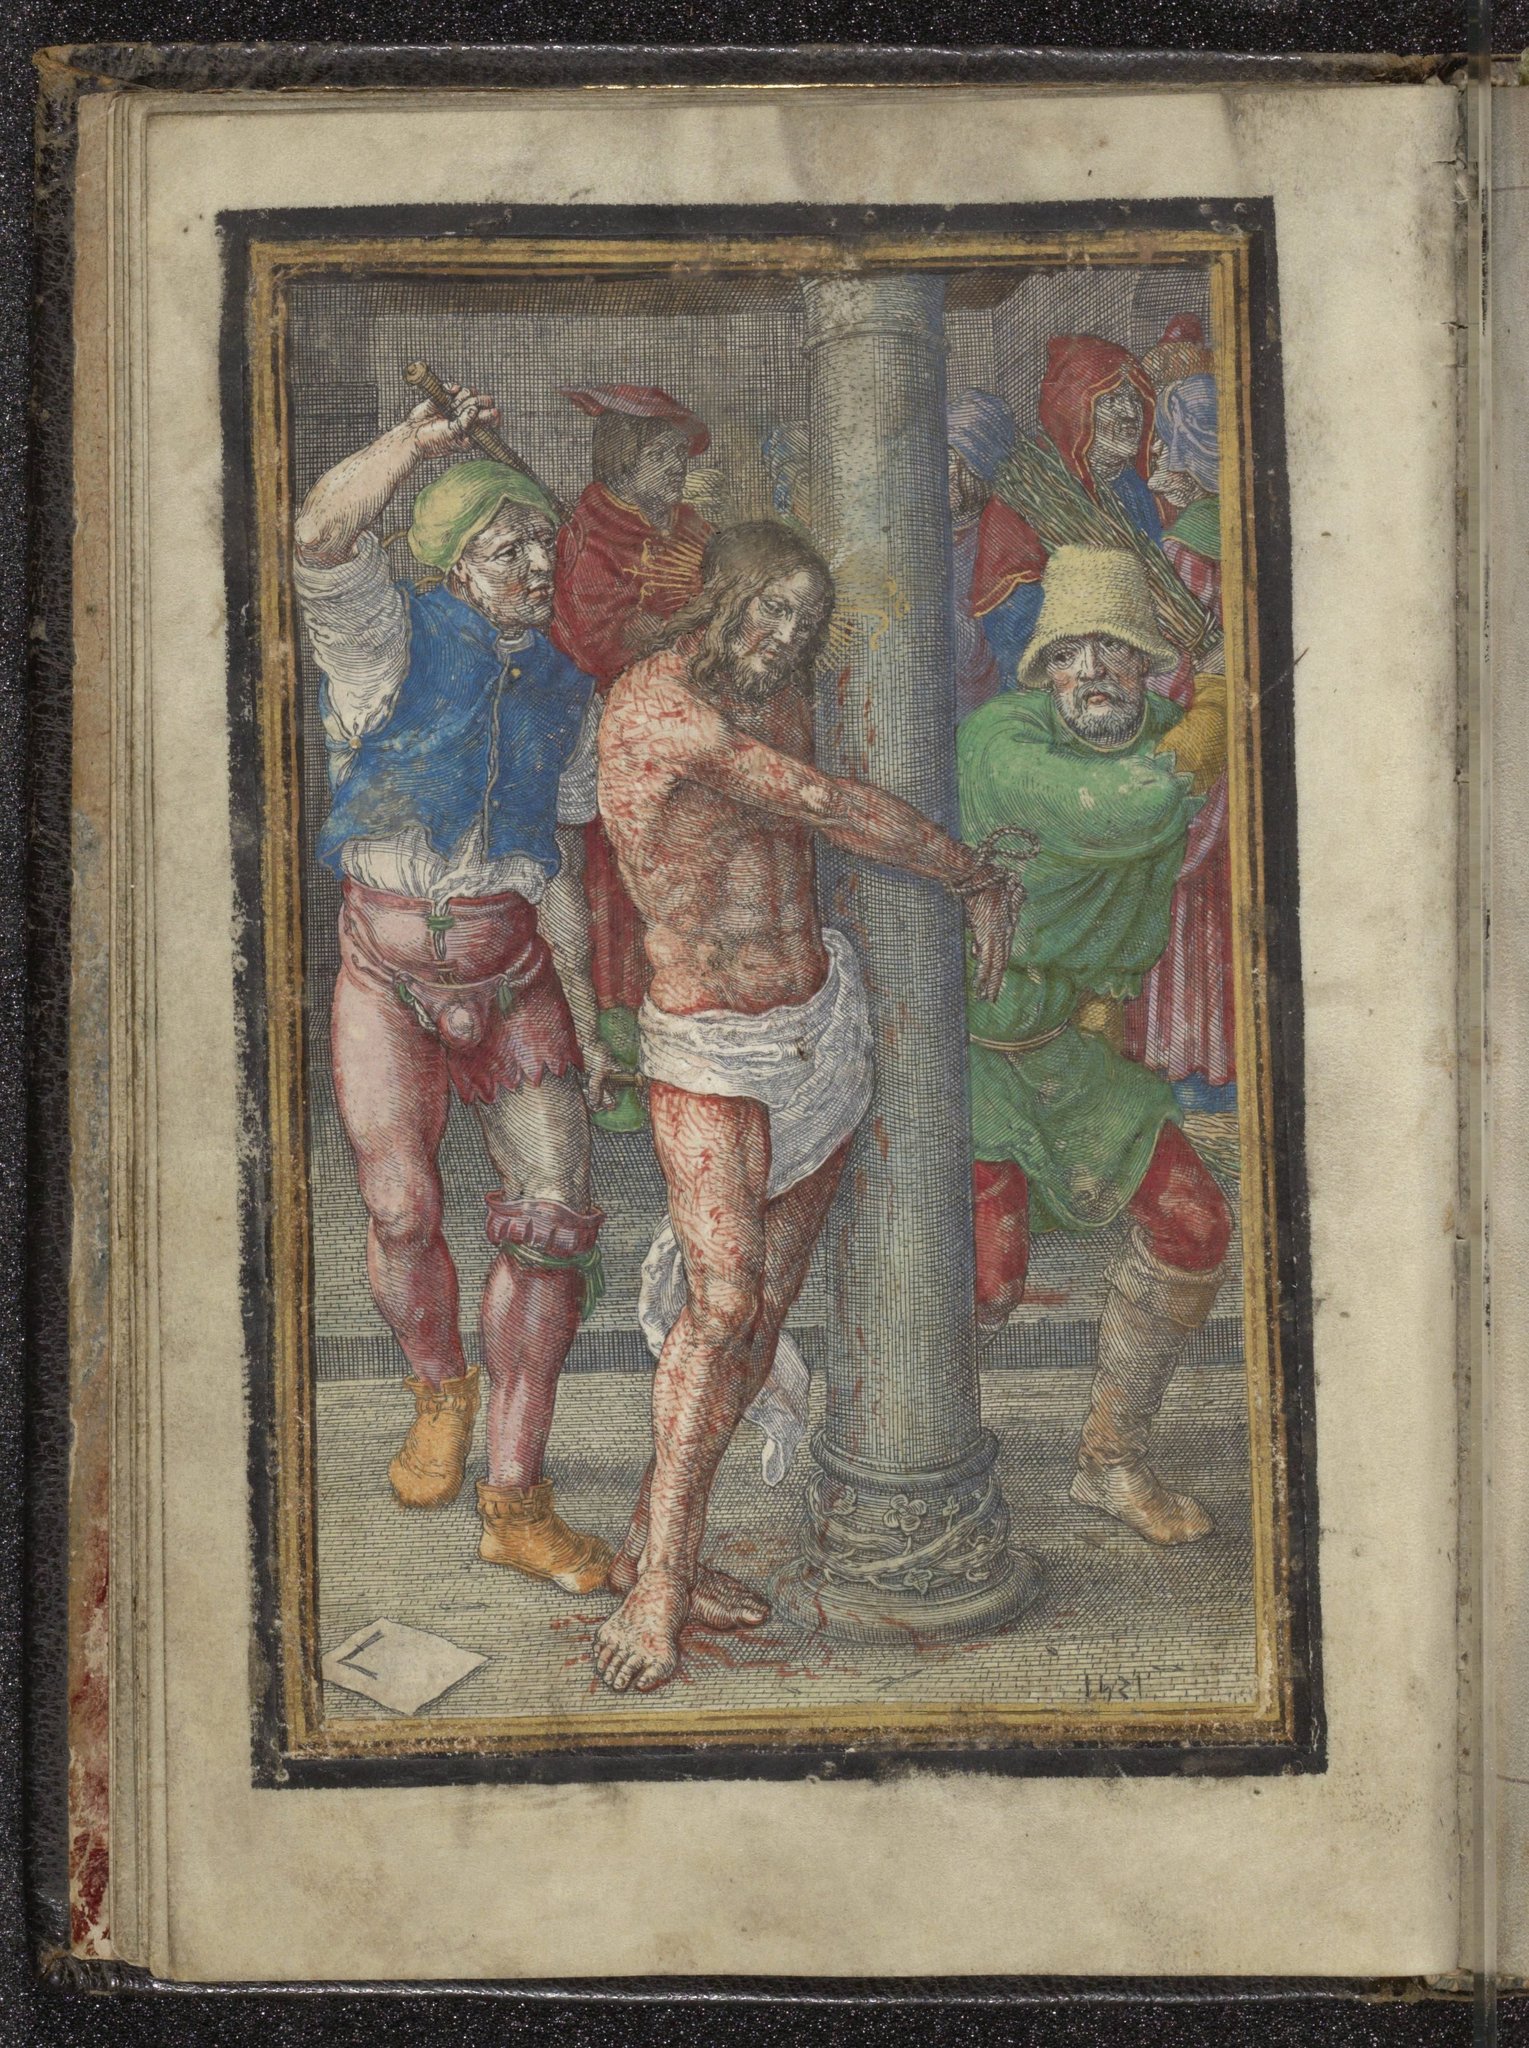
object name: page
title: Geseling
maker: lucas van leyden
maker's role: draughtsman, painter, print maker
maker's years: 1494-1533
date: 1521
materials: paper, parchment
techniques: engraving, hand coloring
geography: leiden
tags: flagellation by soldiers, christ usually tied to a column (matthew 27:26; mark 15:15; john 19:1)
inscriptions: date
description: Christus is vastgebonden aan een zuil en wordt gegeseld met een zweep en roe door twee mannen. Deze prent maakt deel uit van een handgeschreven gebedenboek.